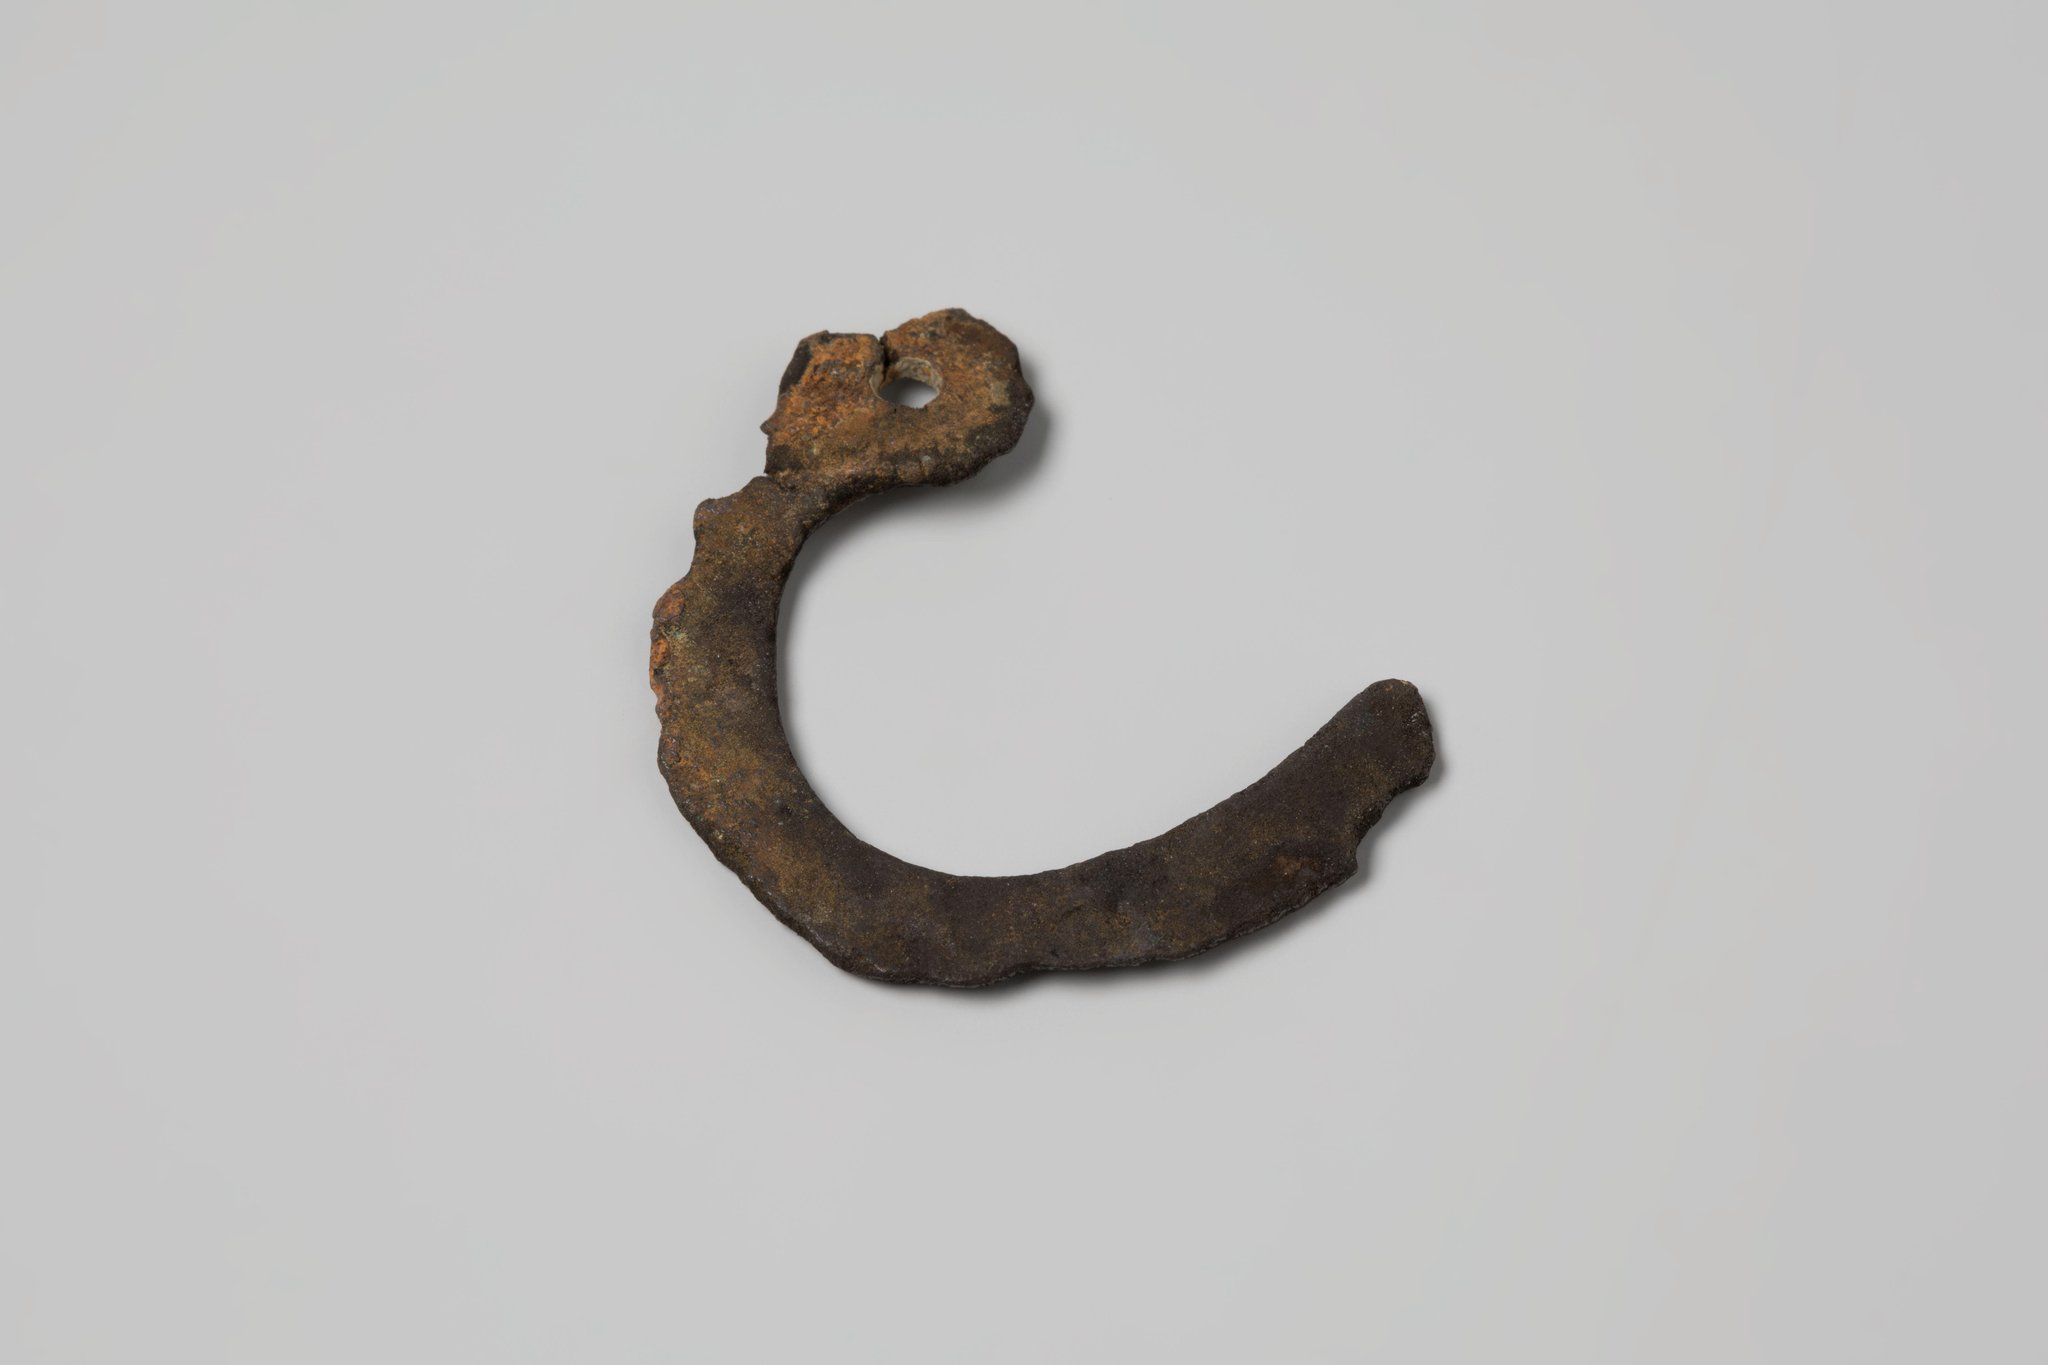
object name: divider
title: Fragment steekpasser uit het wrak van de Oost-Indiëvaarder Hollandia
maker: Anonymous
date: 1700-1743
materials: copper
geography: netherlands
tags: verenigde oostindische compagnie, hollandia (schip), annet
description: Divider; fragment of semicircular ring, id. NG 1980-27H1669, eroded.